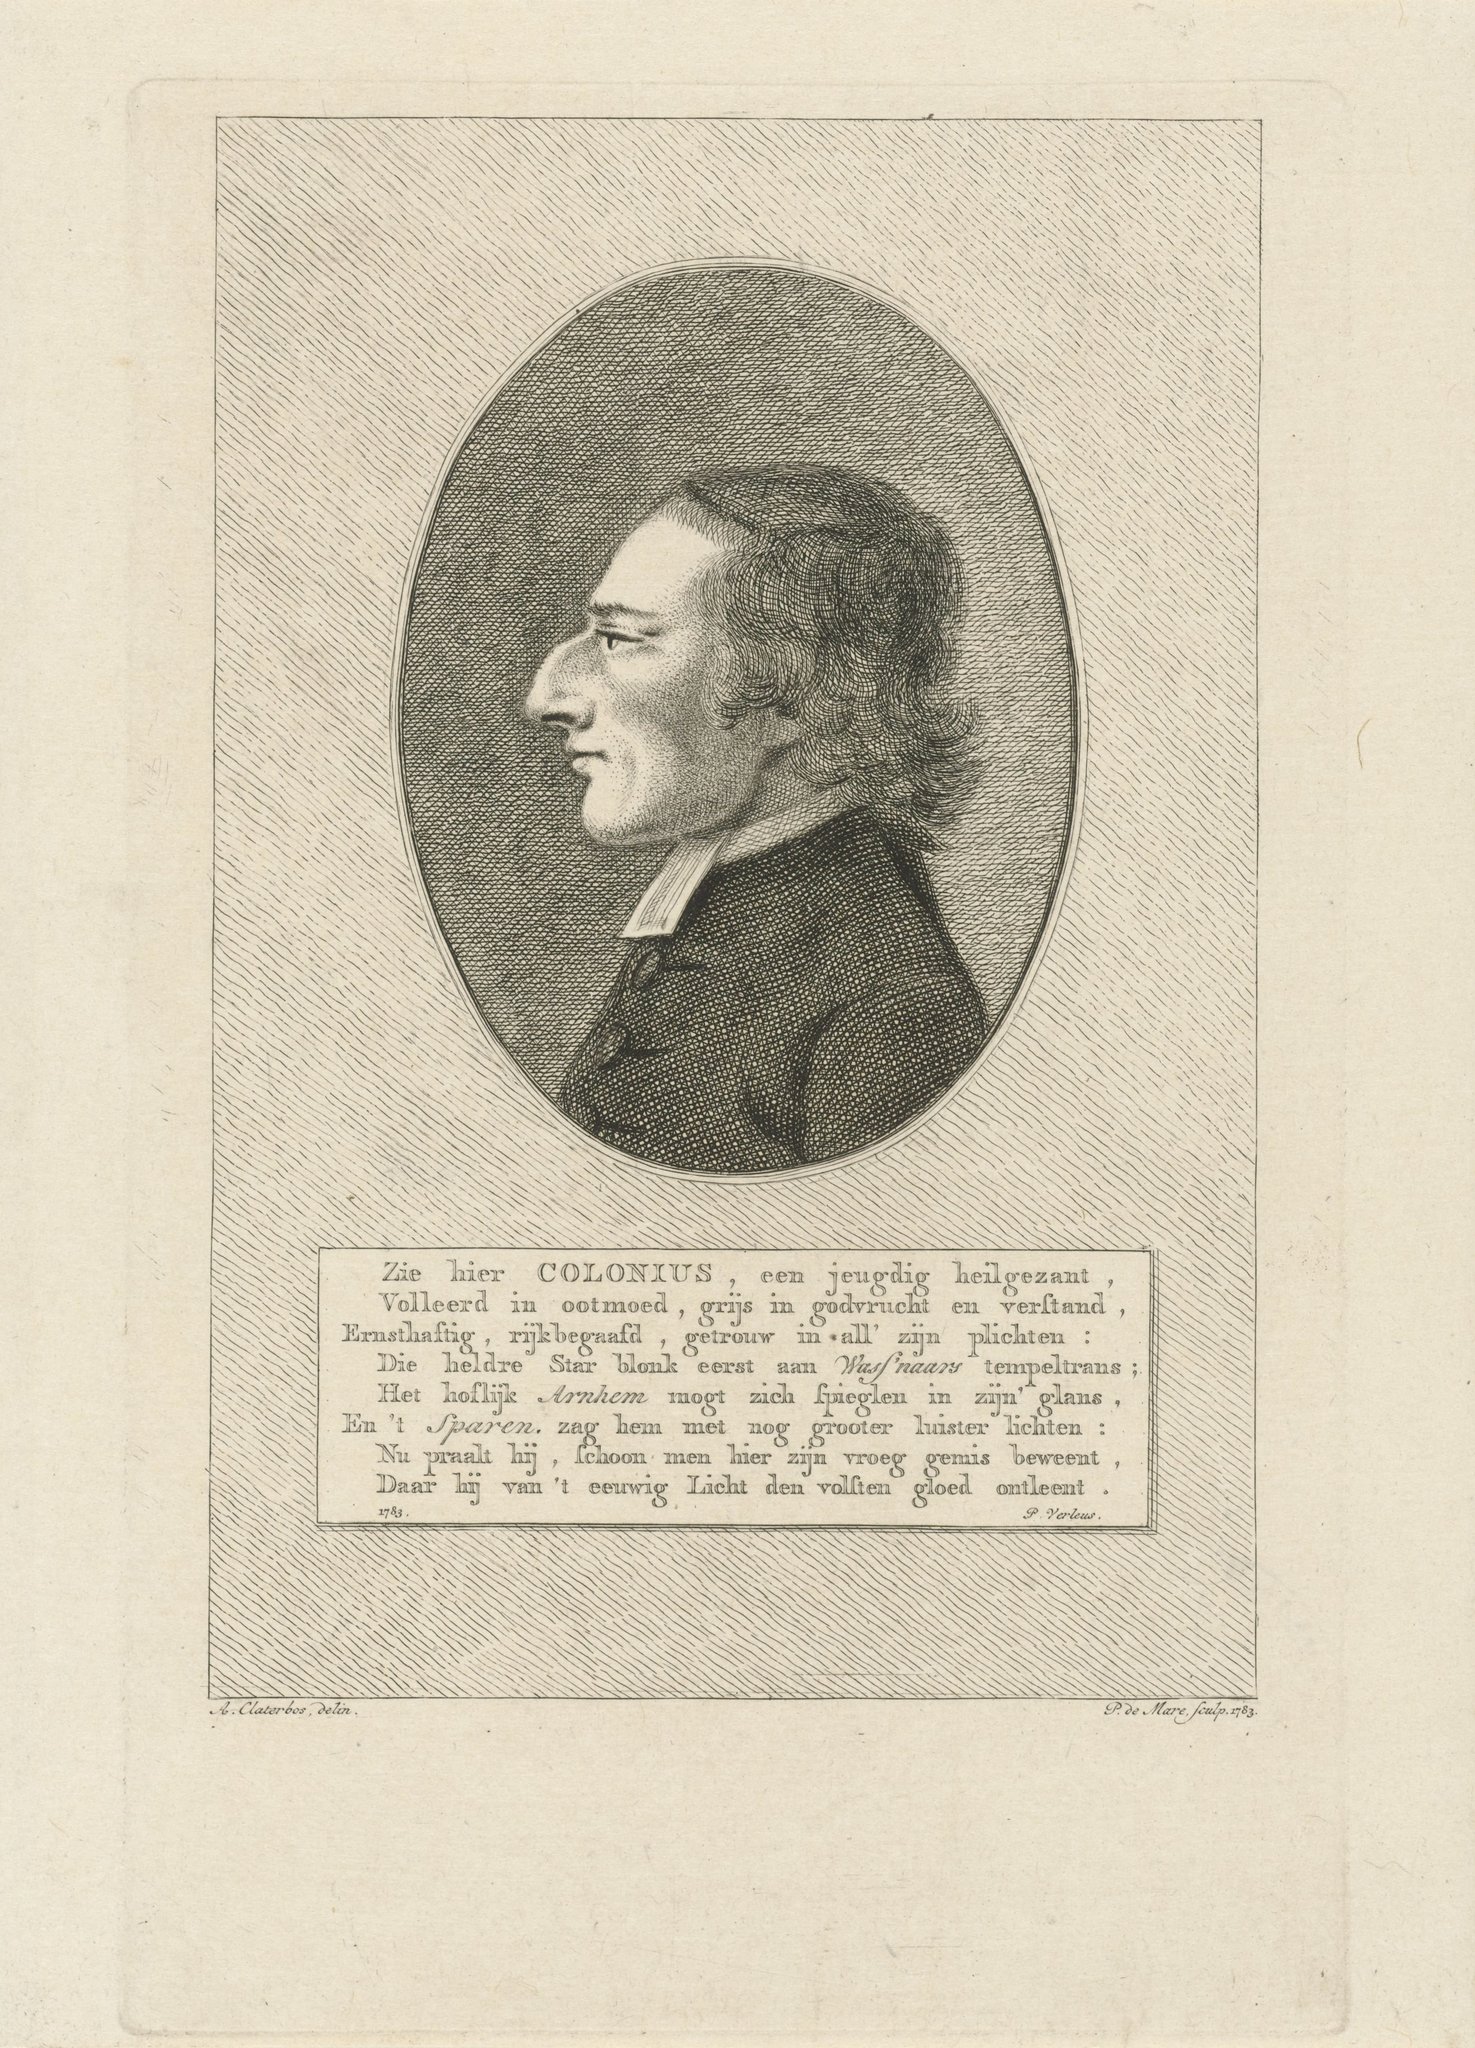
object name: print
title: Portret van Daniel Colonius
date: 1783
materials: paper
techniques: engraving, etching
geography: leiden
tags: leiden, daniel colonius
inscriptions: collector's mark: Lugt 240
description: Portret van de predikant Daniel Colonius.